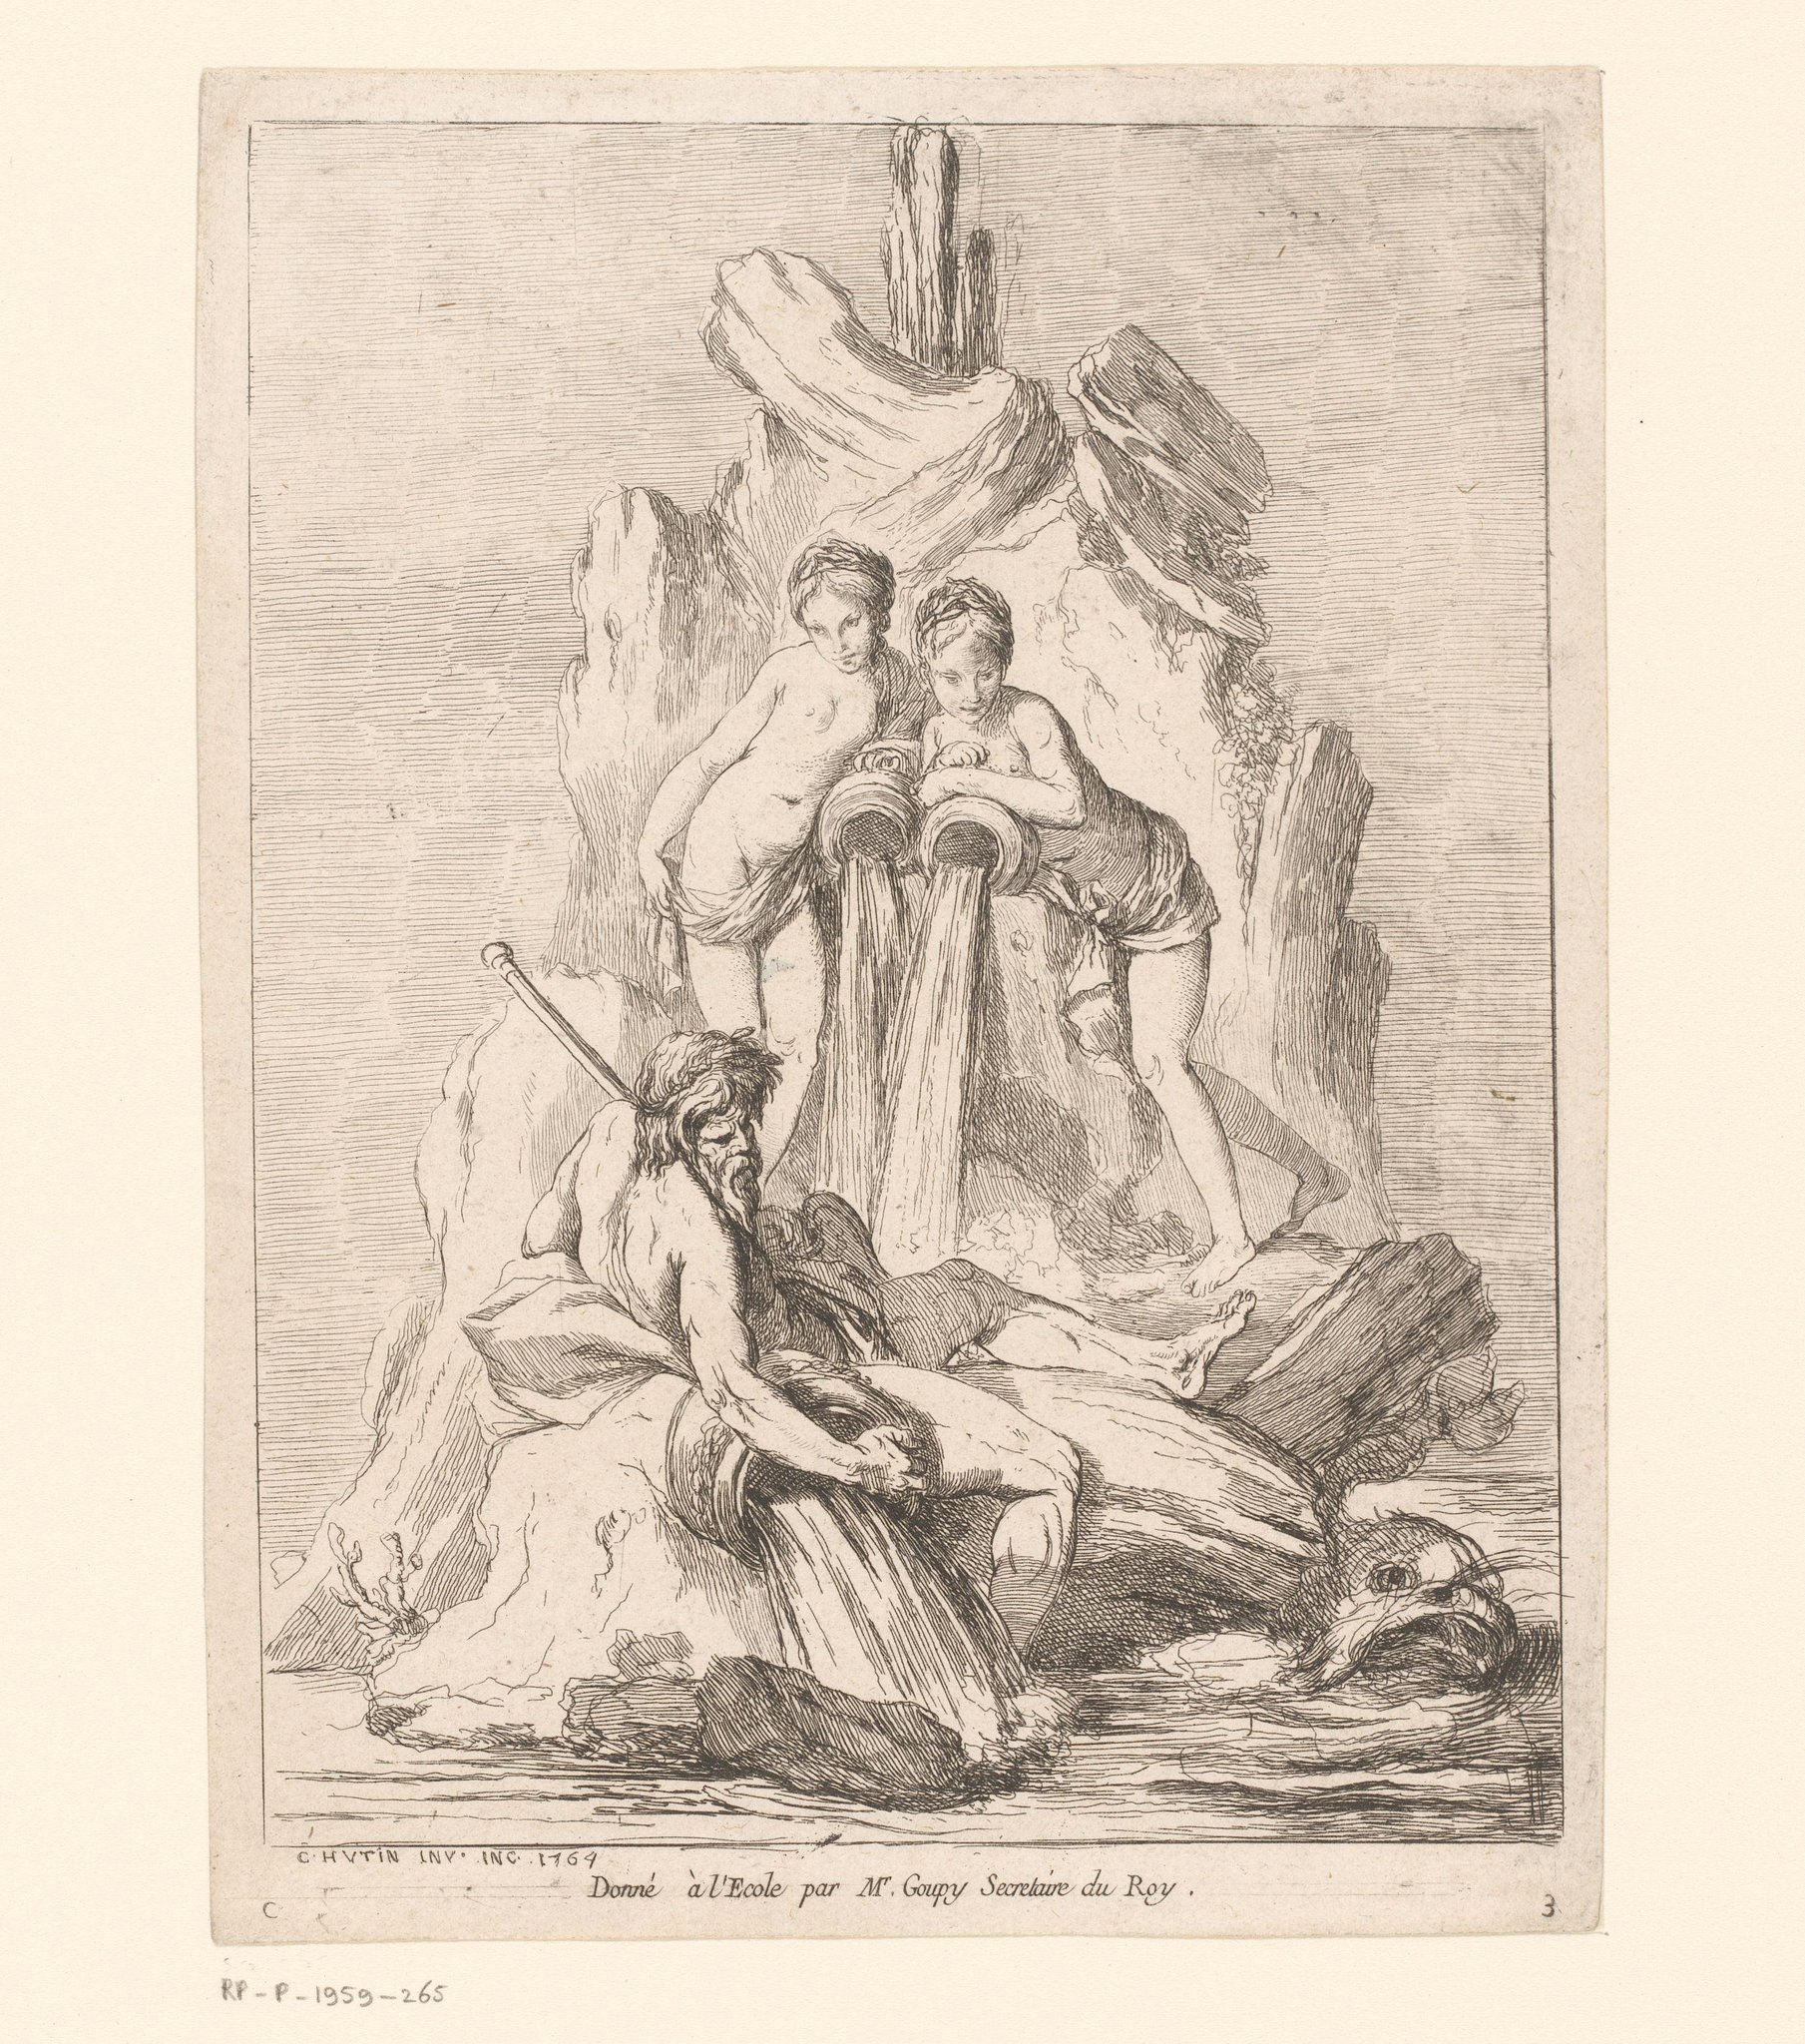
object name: print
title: Fontaines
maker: charles françois hutin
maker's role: draughtsman, print maker, sculptor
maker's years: 1715-1776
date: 1764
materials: paper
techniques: etching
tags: nymphs (in general); 'ninfe in commune' (ripa), river-gods, ornamental fountain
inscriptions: collector's mark: Lugt 2760, collector's mark: Lugt 2228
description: Maakt deel uit van een vijfdelige serie met fonteinen.